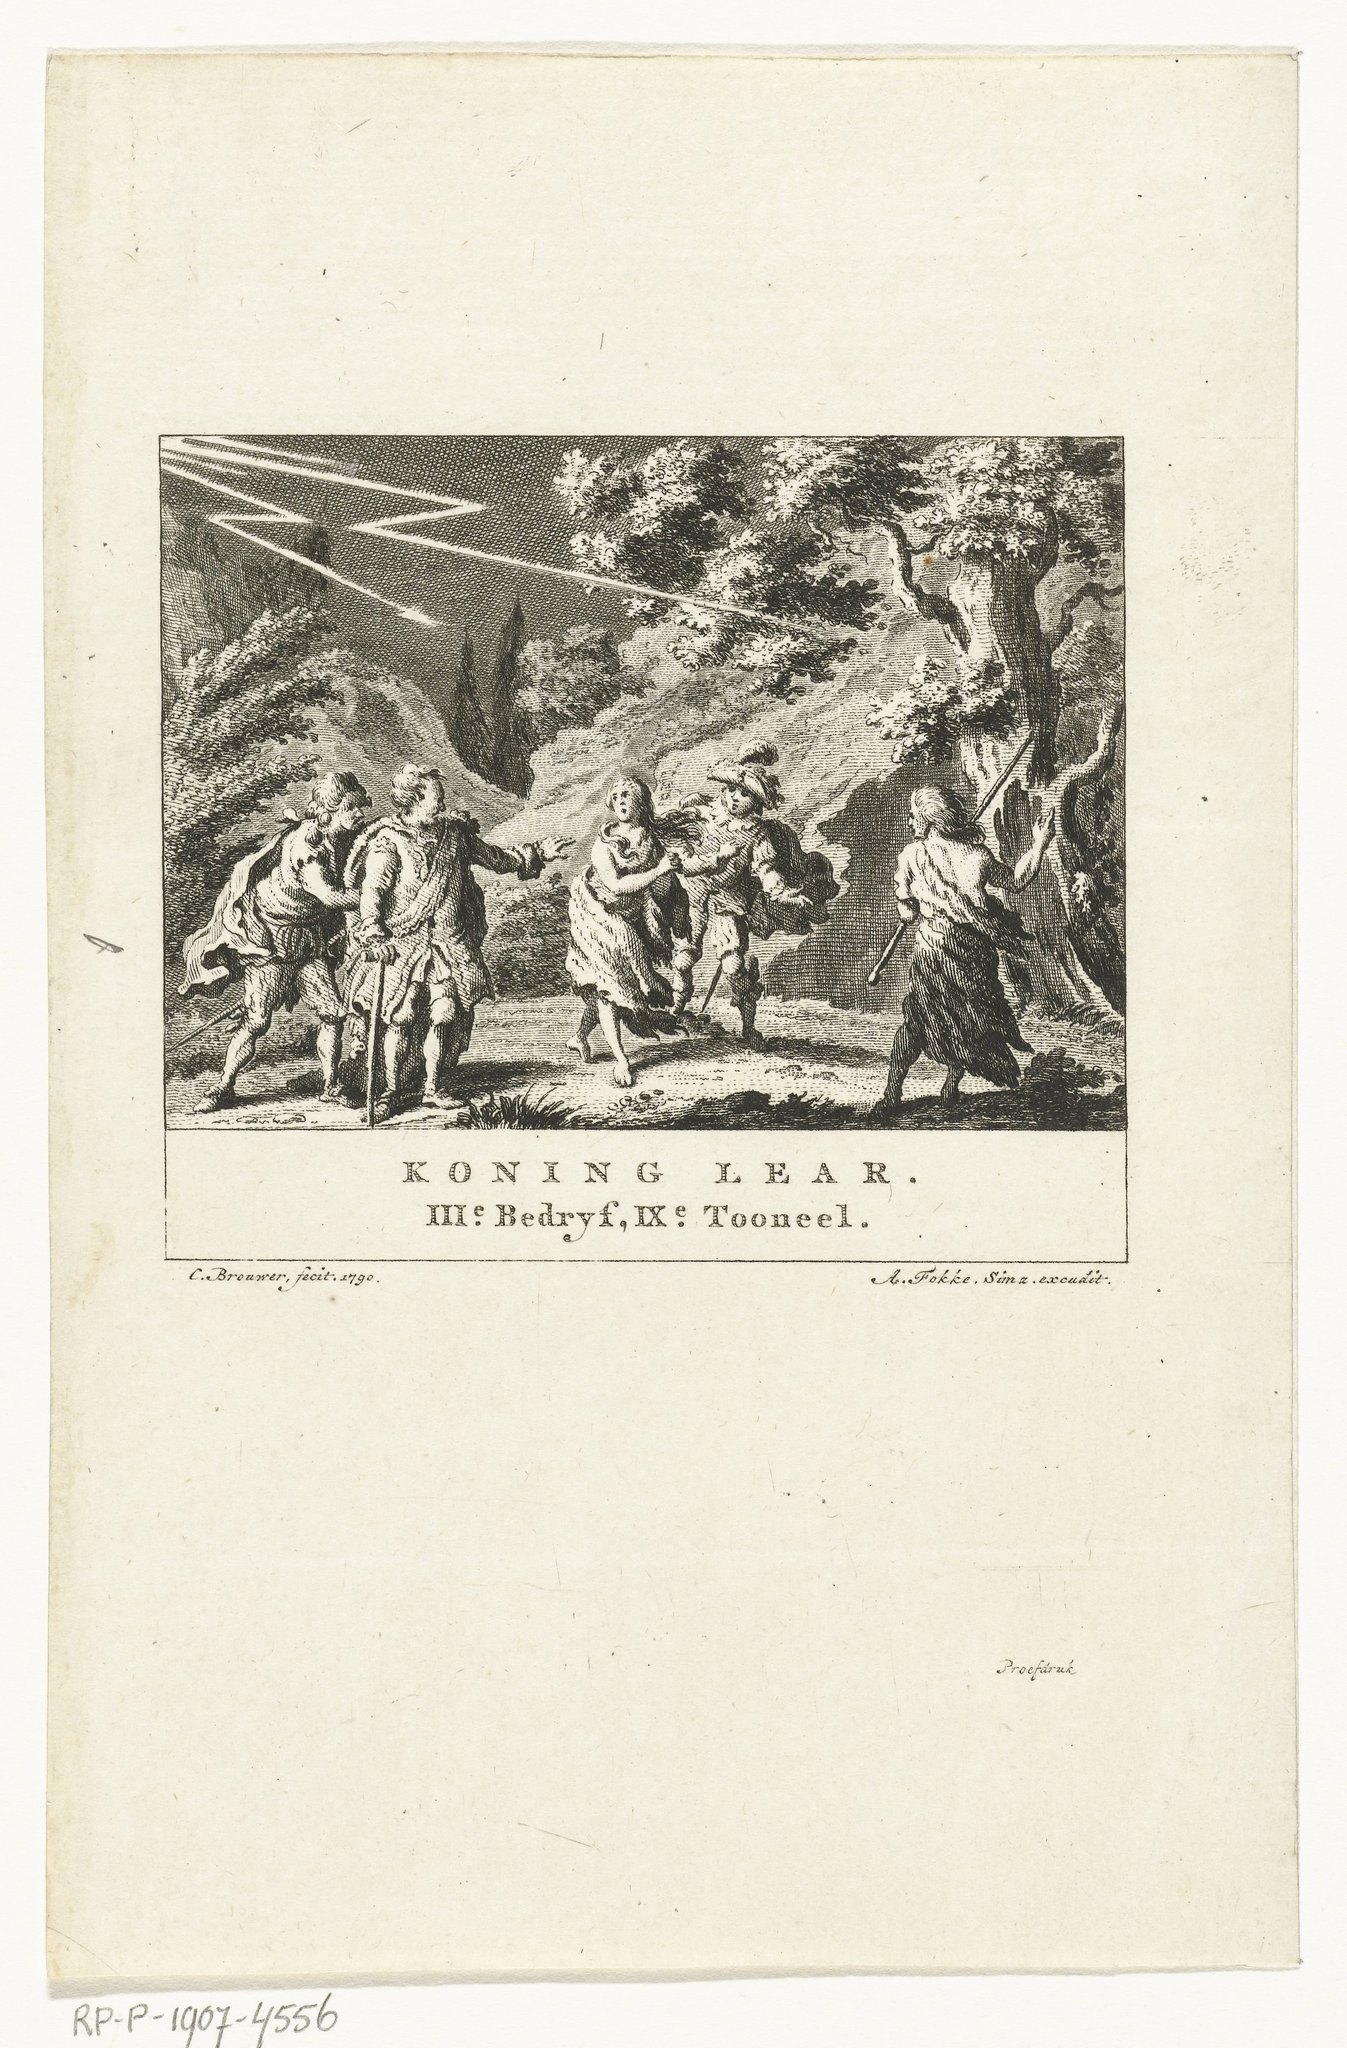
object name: print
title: Koning Lear. IIIe Bedrijf, IXe Tooneel.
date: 1790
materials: paper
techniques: etching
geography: amsterdam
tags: king lear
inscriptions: collector's mark: Lugt 2228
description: Scène uit toneelstuk Koning Lear met onder andere hoofdrolspelers Lear, Kent en Gloucester tijdens storm waarbij bliksemschichten door de lucht schieten.